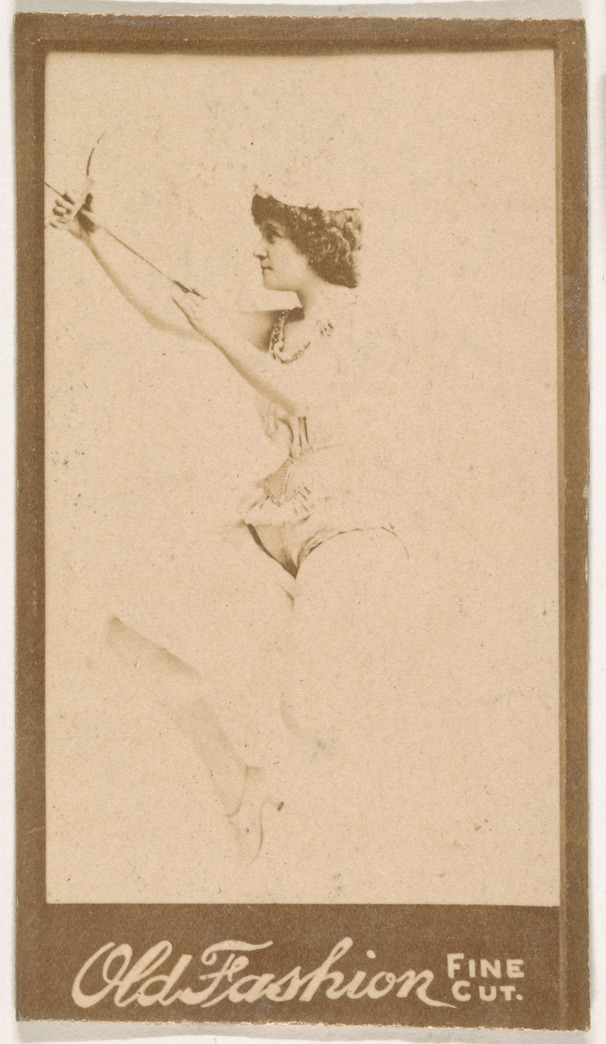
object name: photograph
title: Actress with bow and arrow, from the Actresses series (N664) promoting Old Fashion Fine Cut Tobacco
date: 1888-1890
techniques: albumen silver print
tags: bow and arrow,portraits,women,actresses